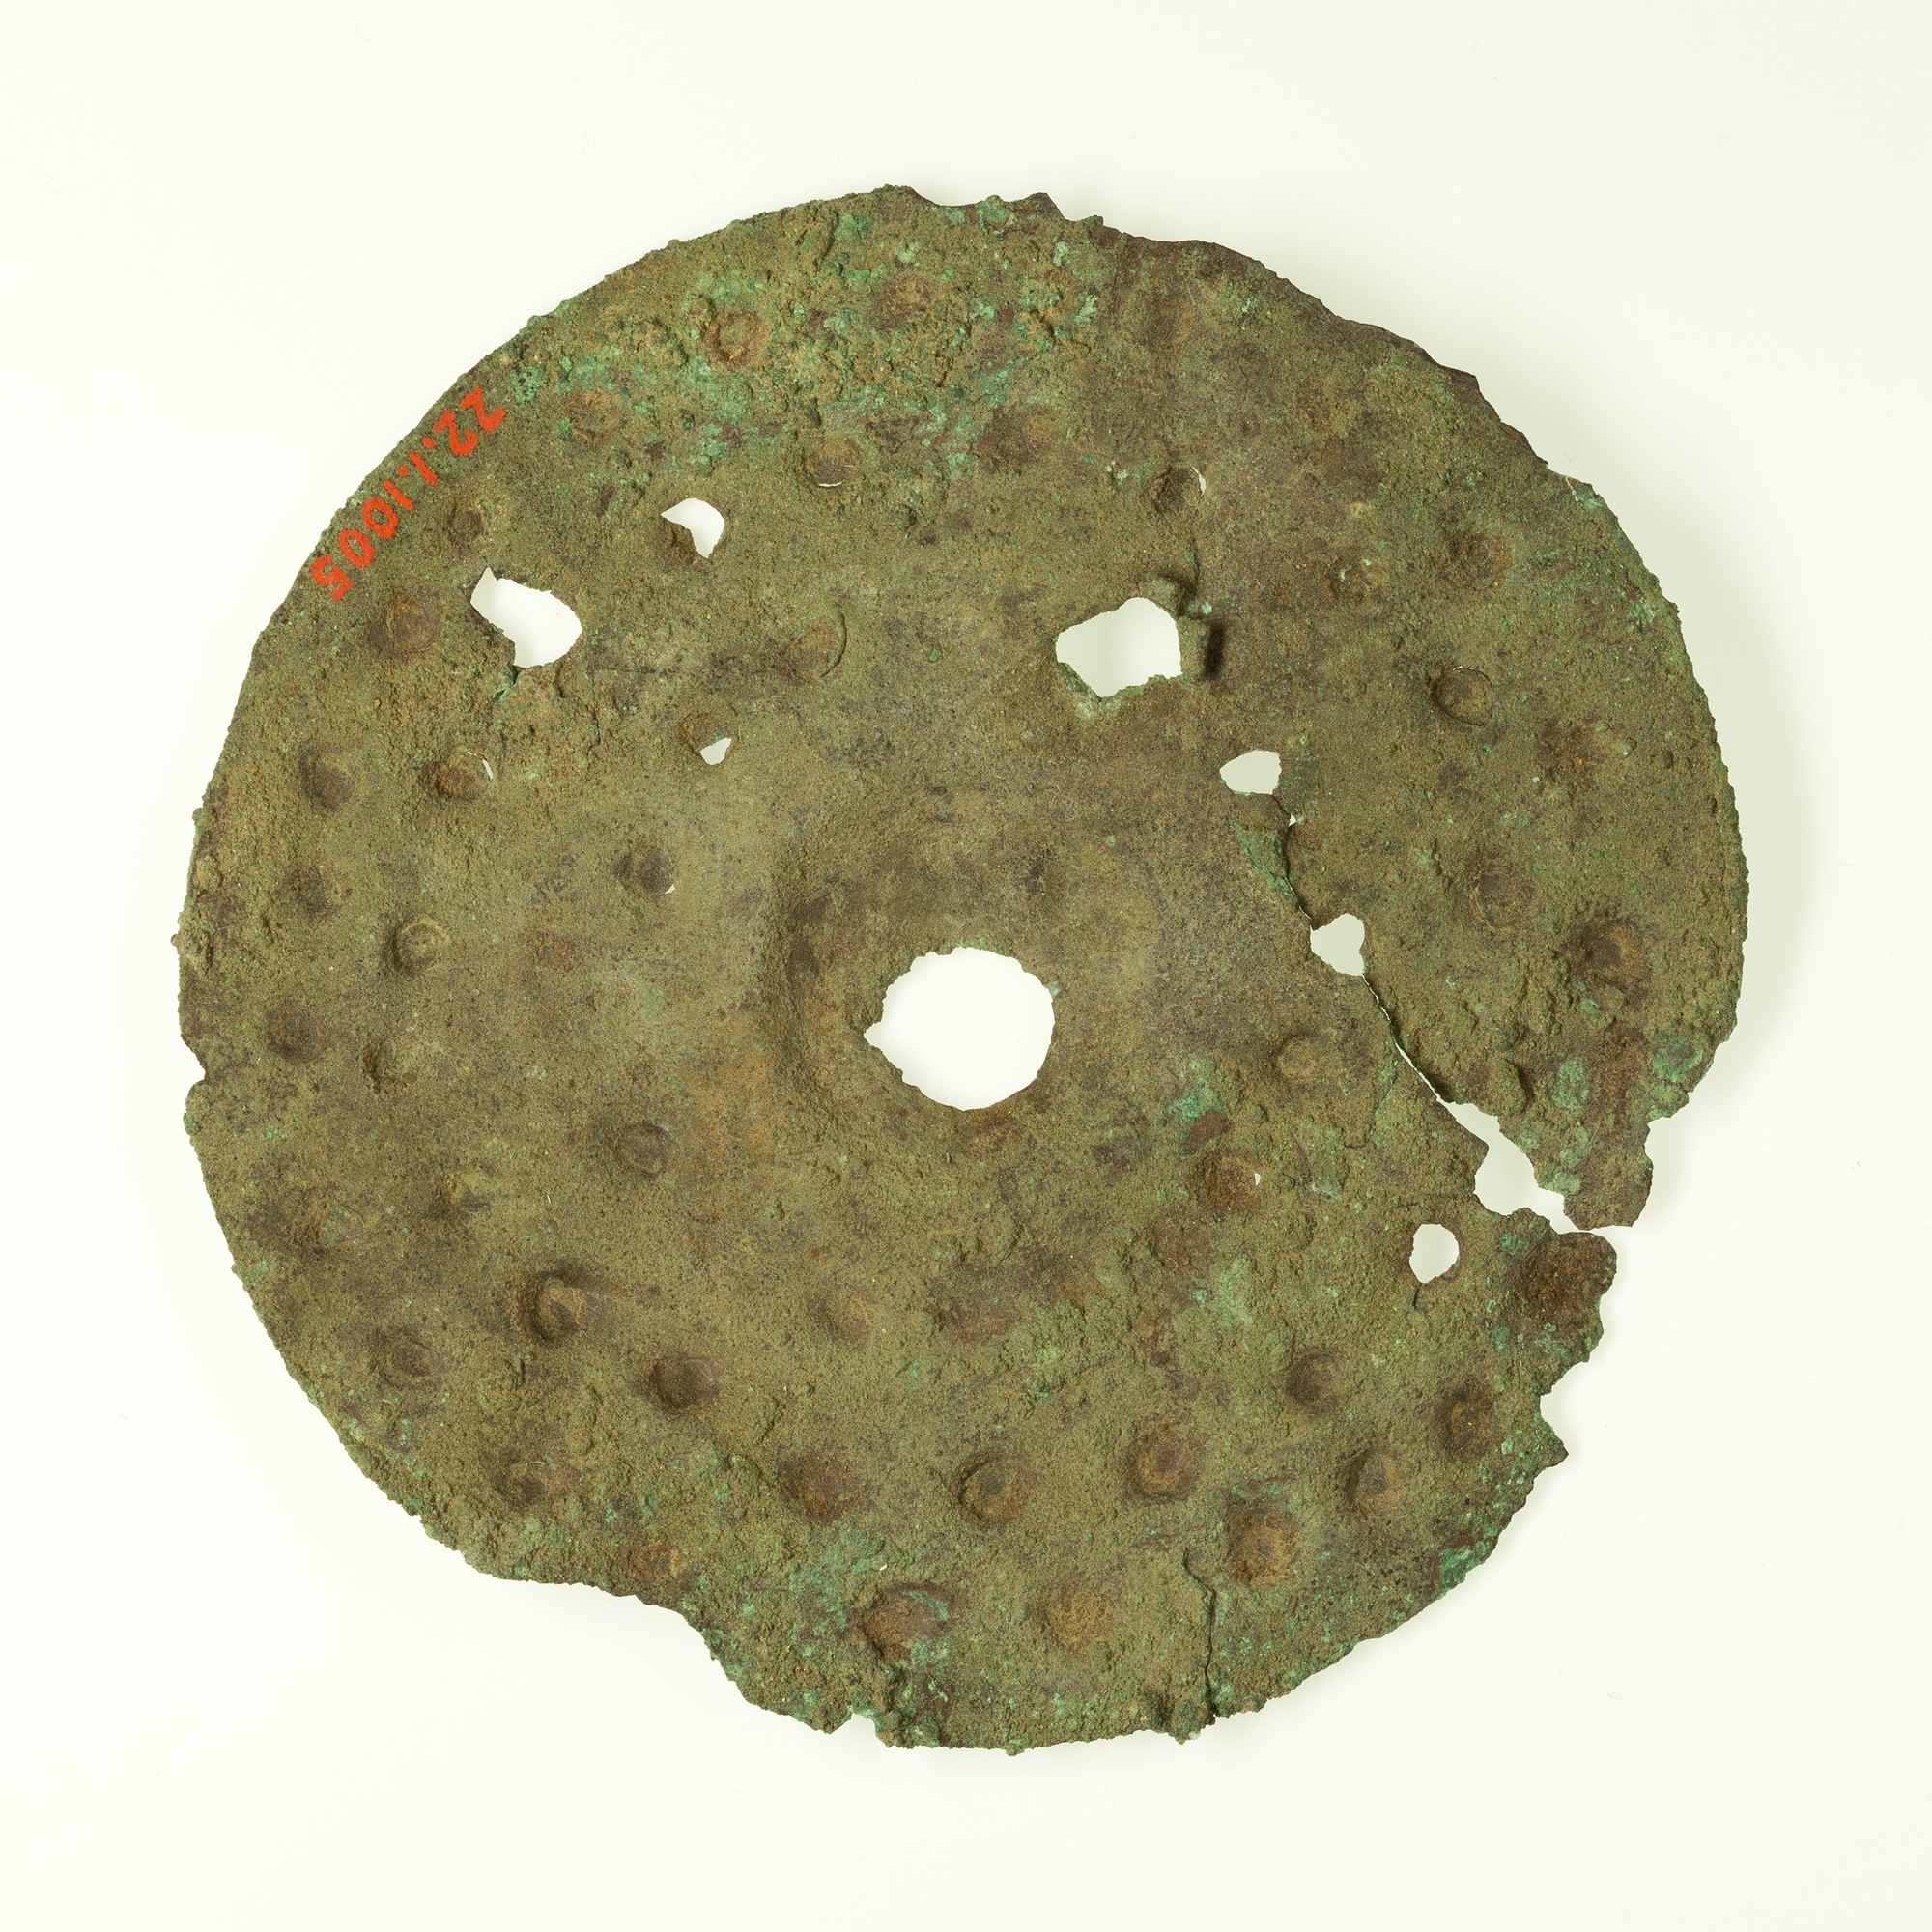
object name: disc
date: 1295-1070 BCE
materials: bronze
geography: egypt